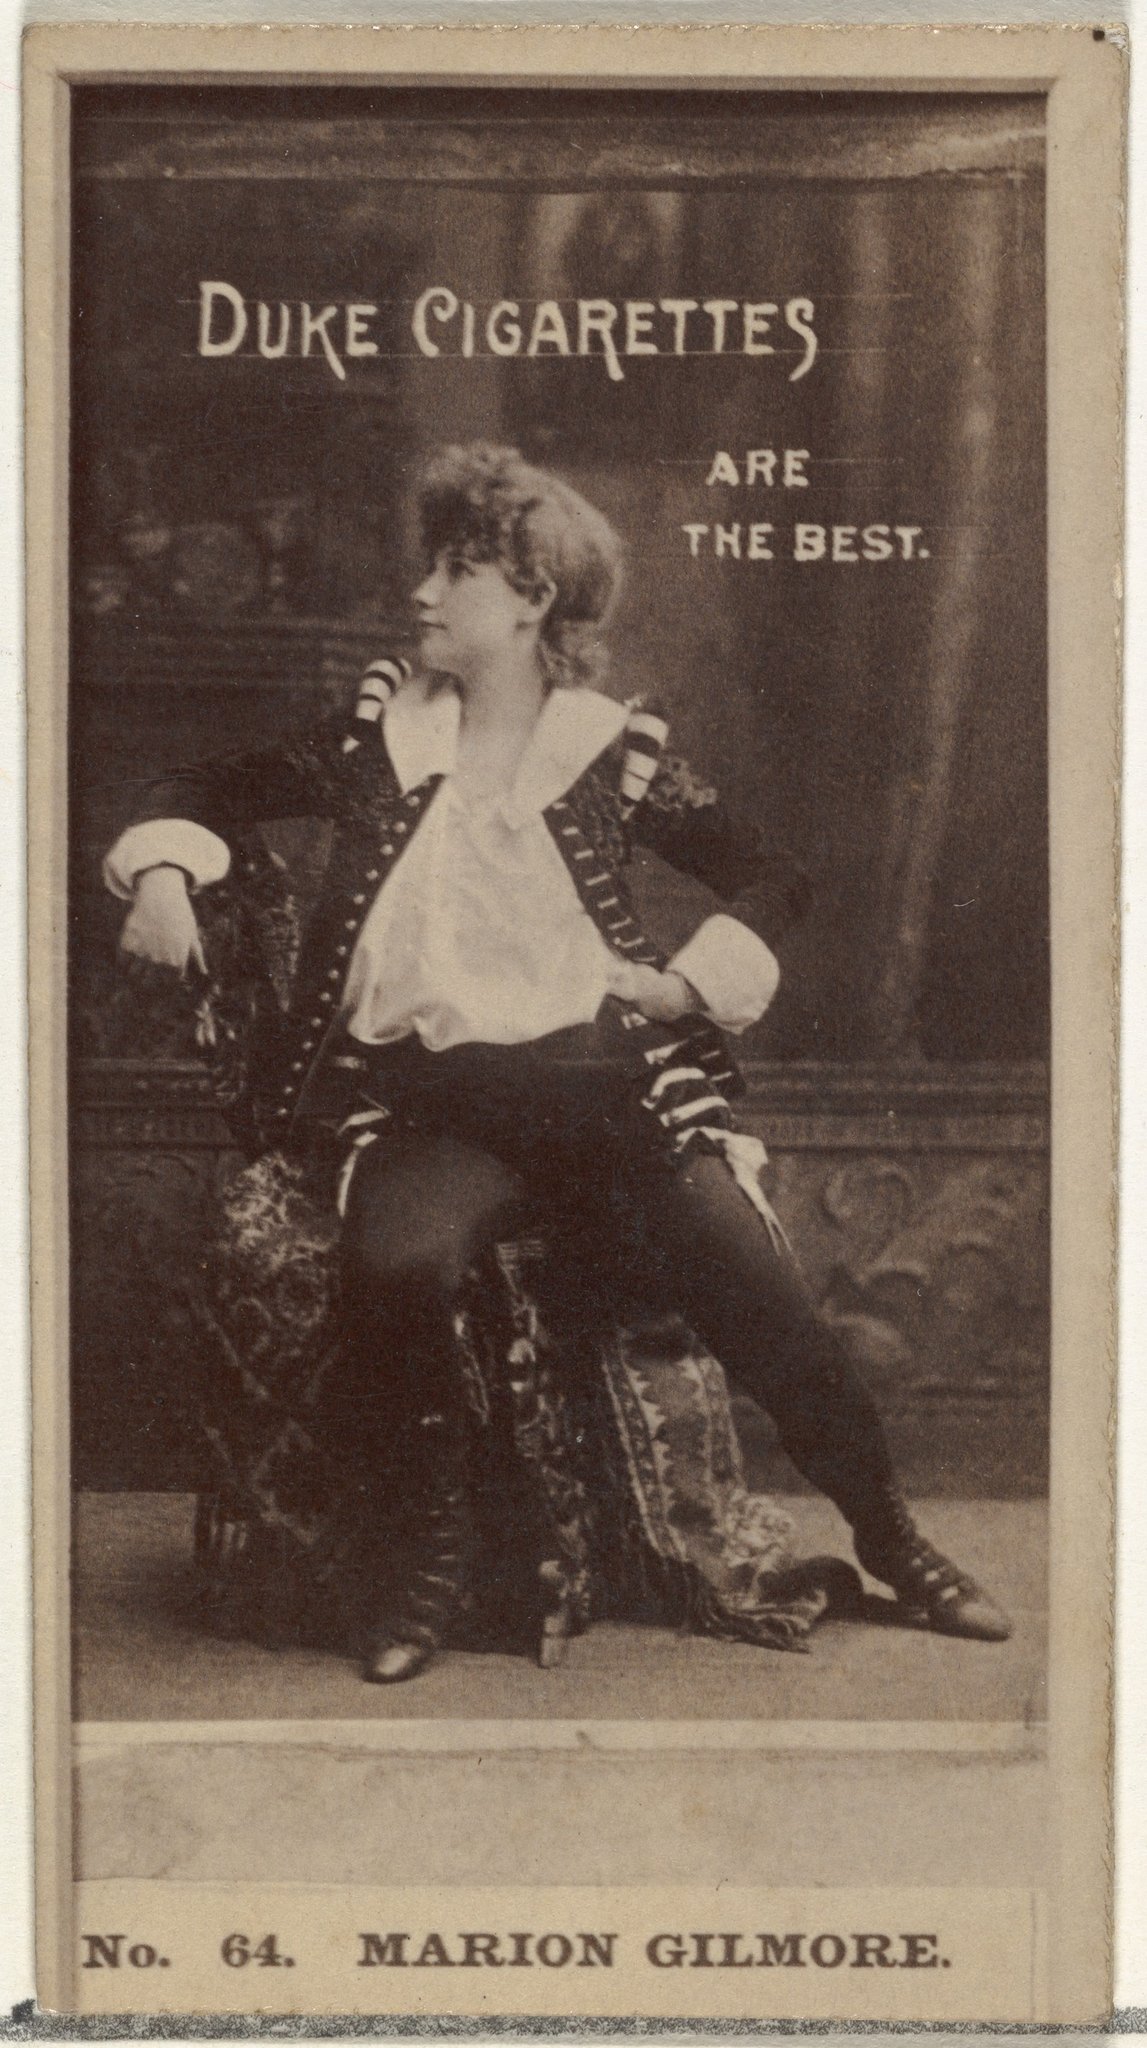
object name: photograph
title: Card Number 64, Marion Gilmore, from the Actors and Actresses series (N145-6) issued by Duke Sons & Co. to promote Duke Cigarettes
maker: w. duke, sons & co.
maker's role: publisher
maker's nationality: american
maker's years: 1870-1920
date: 1880-1889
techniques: albumen silver print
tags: women,actresses